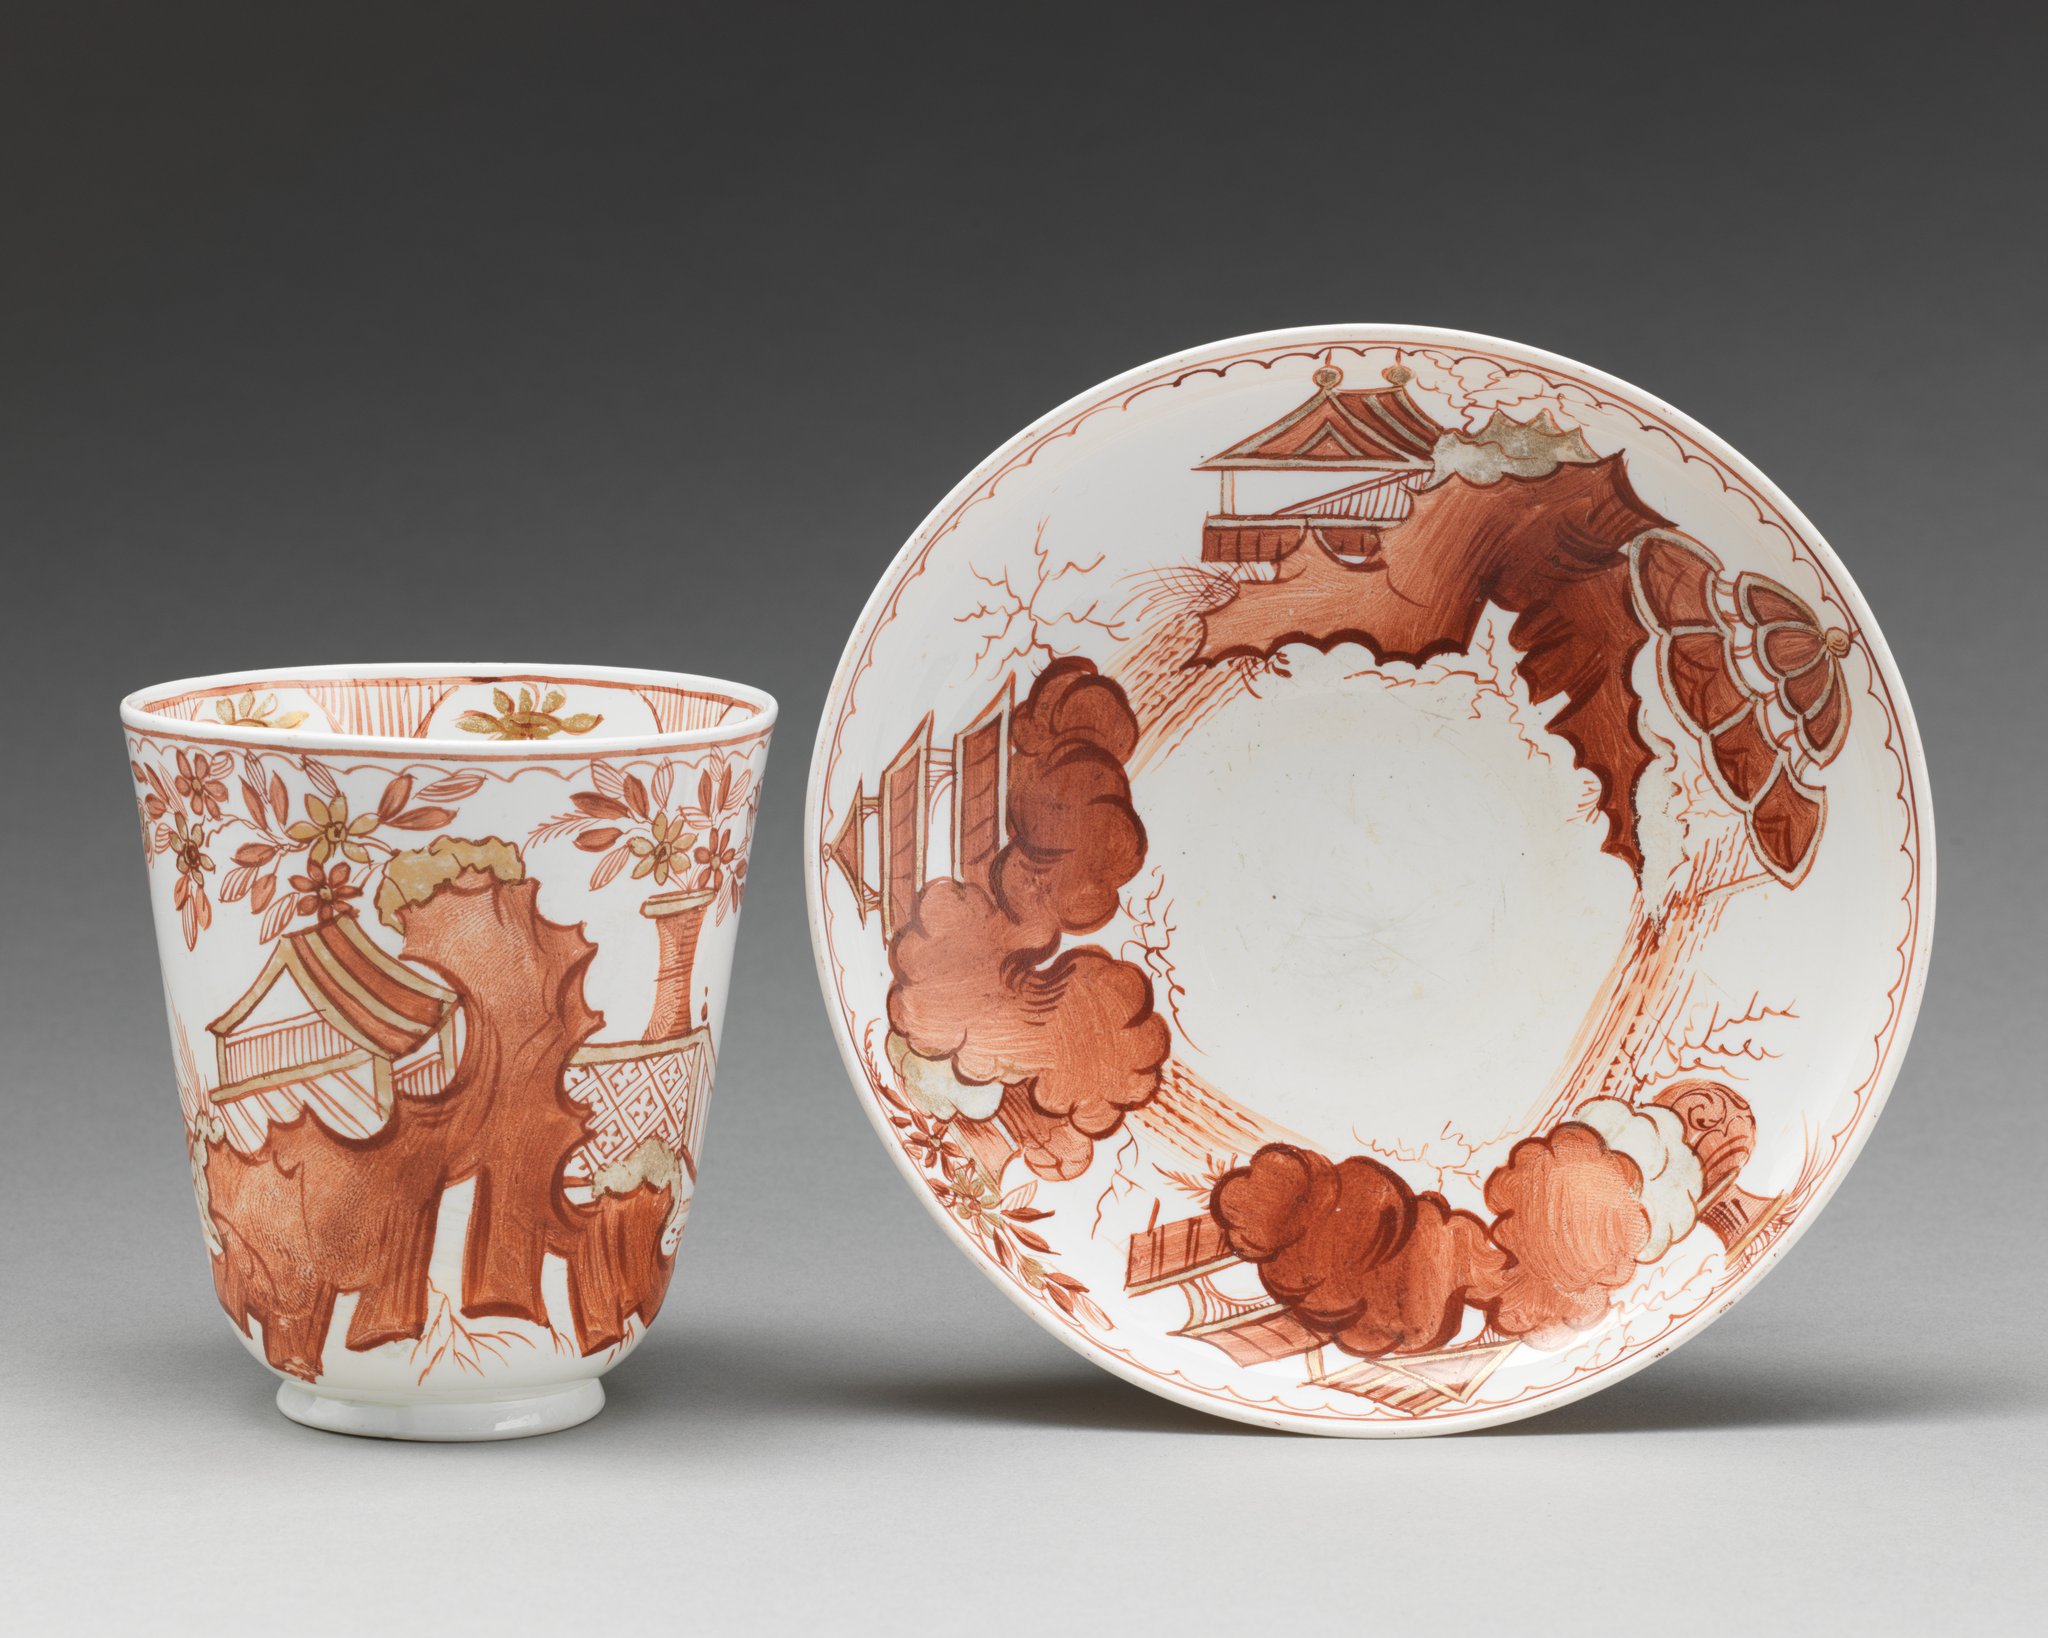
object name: beaker and saucer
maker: miotti family workshop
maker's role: manufactory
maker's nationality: italian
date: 1701-1800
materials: enamel, glass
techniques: gilding